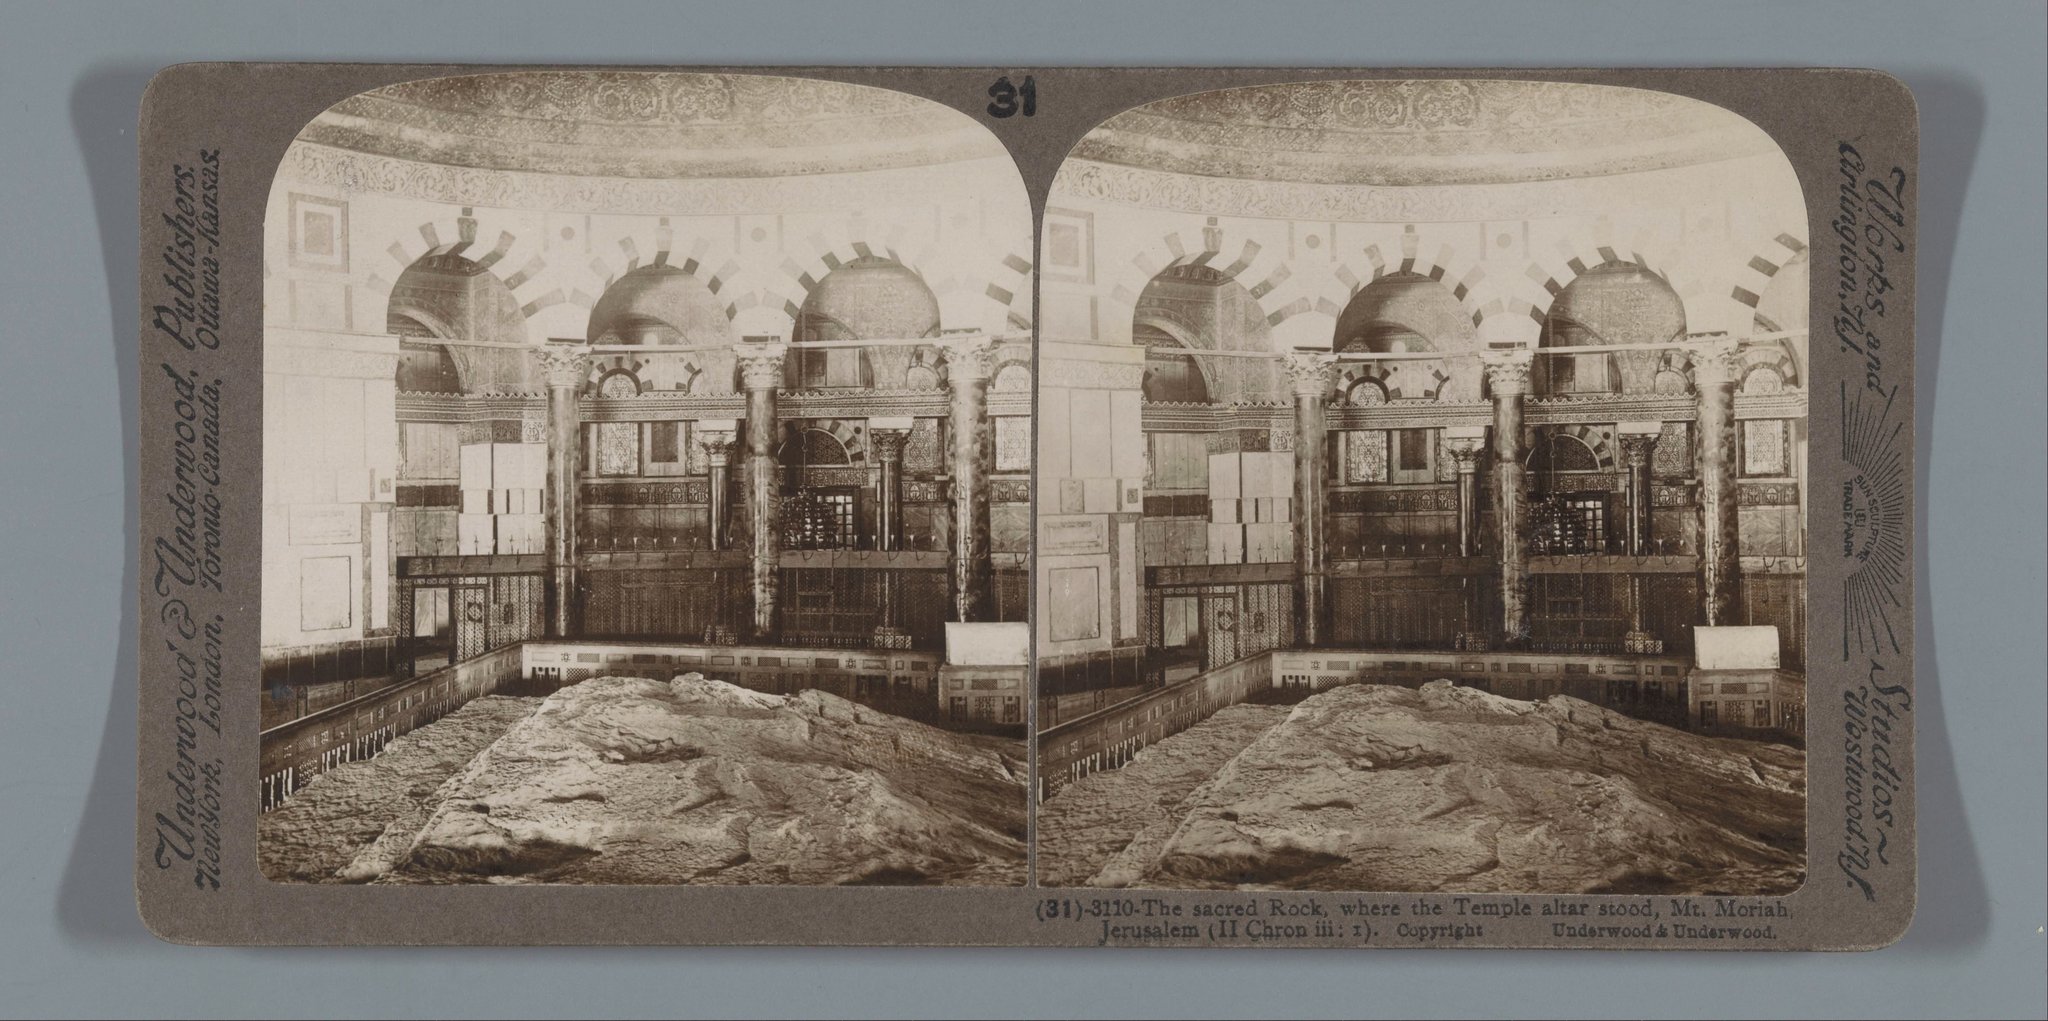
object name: stereograph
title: Heilige rots in de Rotskoepel, Jerusalem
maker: Anonymous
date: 1900-1905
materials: paper, cardboard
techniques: gelatin silver print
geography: jerusalem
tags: temple, shrine ~ islam, mohammedanism, rock-formations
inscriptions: copyright notice: ‘Copyright Underwood & Underwood.’, number: ‘(31)-3110-’, inscription, inscription: ‘Works and Studios ~/ Arlington, N.J. Westwood, N.J.’, number: ‘31’